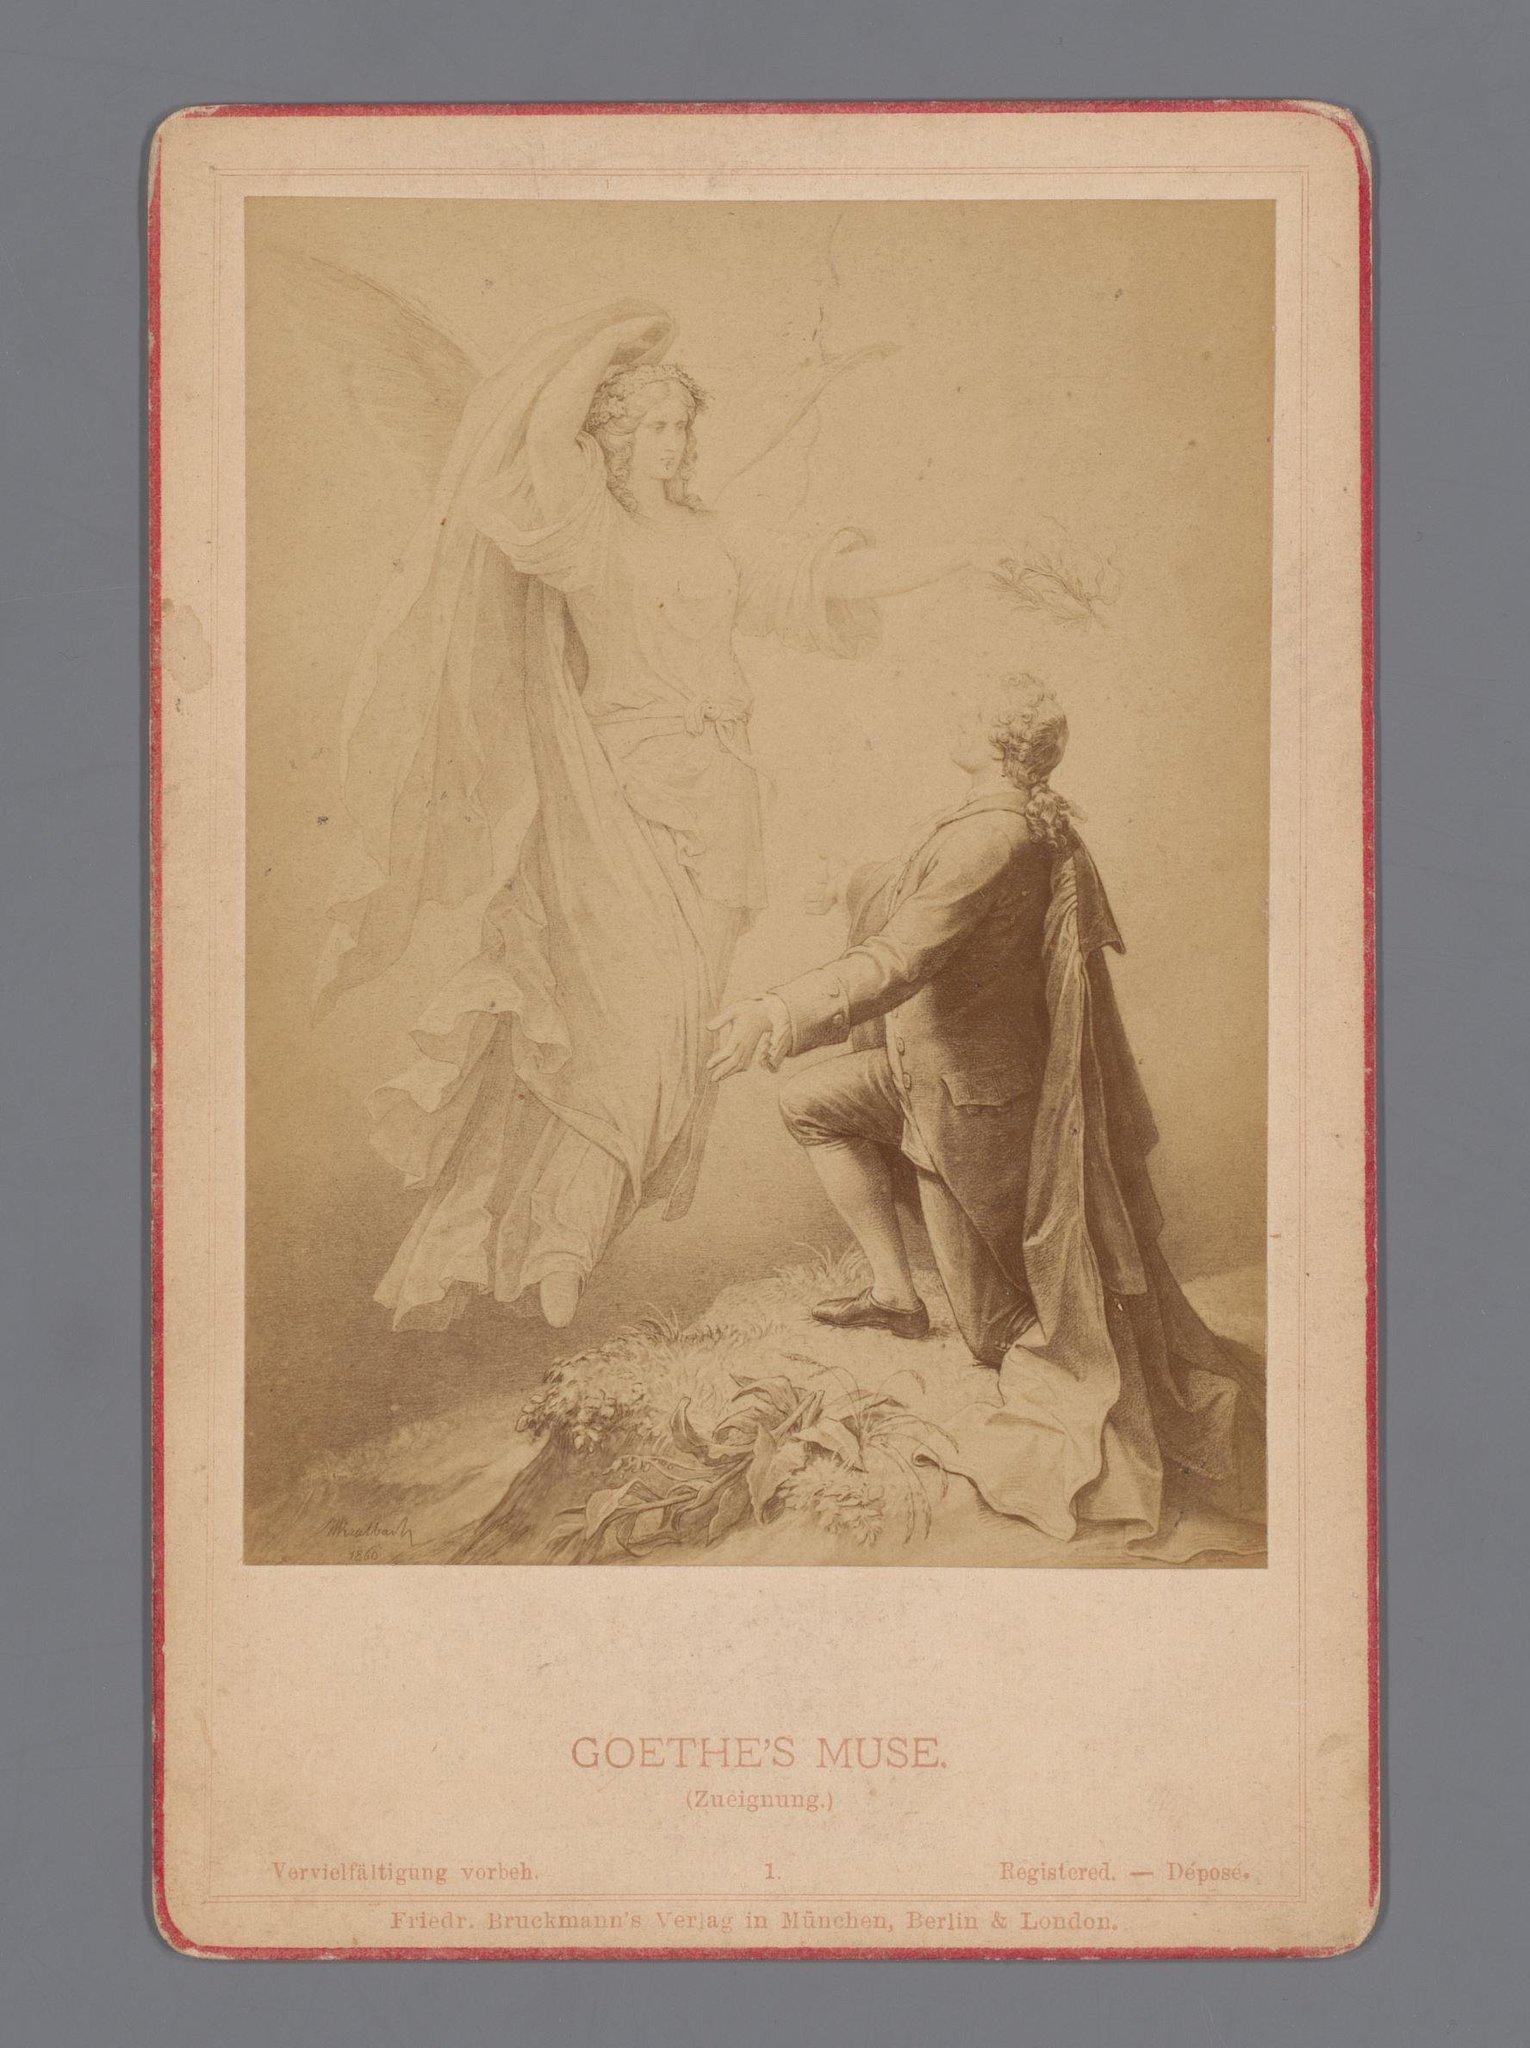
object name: reproduction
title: Fotoreproductie van schilderij [?] 'Goethes Muse (Zueignung)'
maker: friedrich bruckmann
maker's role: publisher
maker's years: 1814-1898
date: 1870-1910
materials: cardboard, paper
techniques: albumen print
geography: munich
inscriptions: inscription: ‘Friedr. Bruckmann's Verlag in München, Berlin & London.’, inscription: ‘Verfielfältigung vorbeh.//Registered. - Déposé’, inscription: ‘Goethe's Muse (Zuneigung)’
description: Fotoreproductie van schilderij [?] 'Goethes Muse (Zueignung)'.